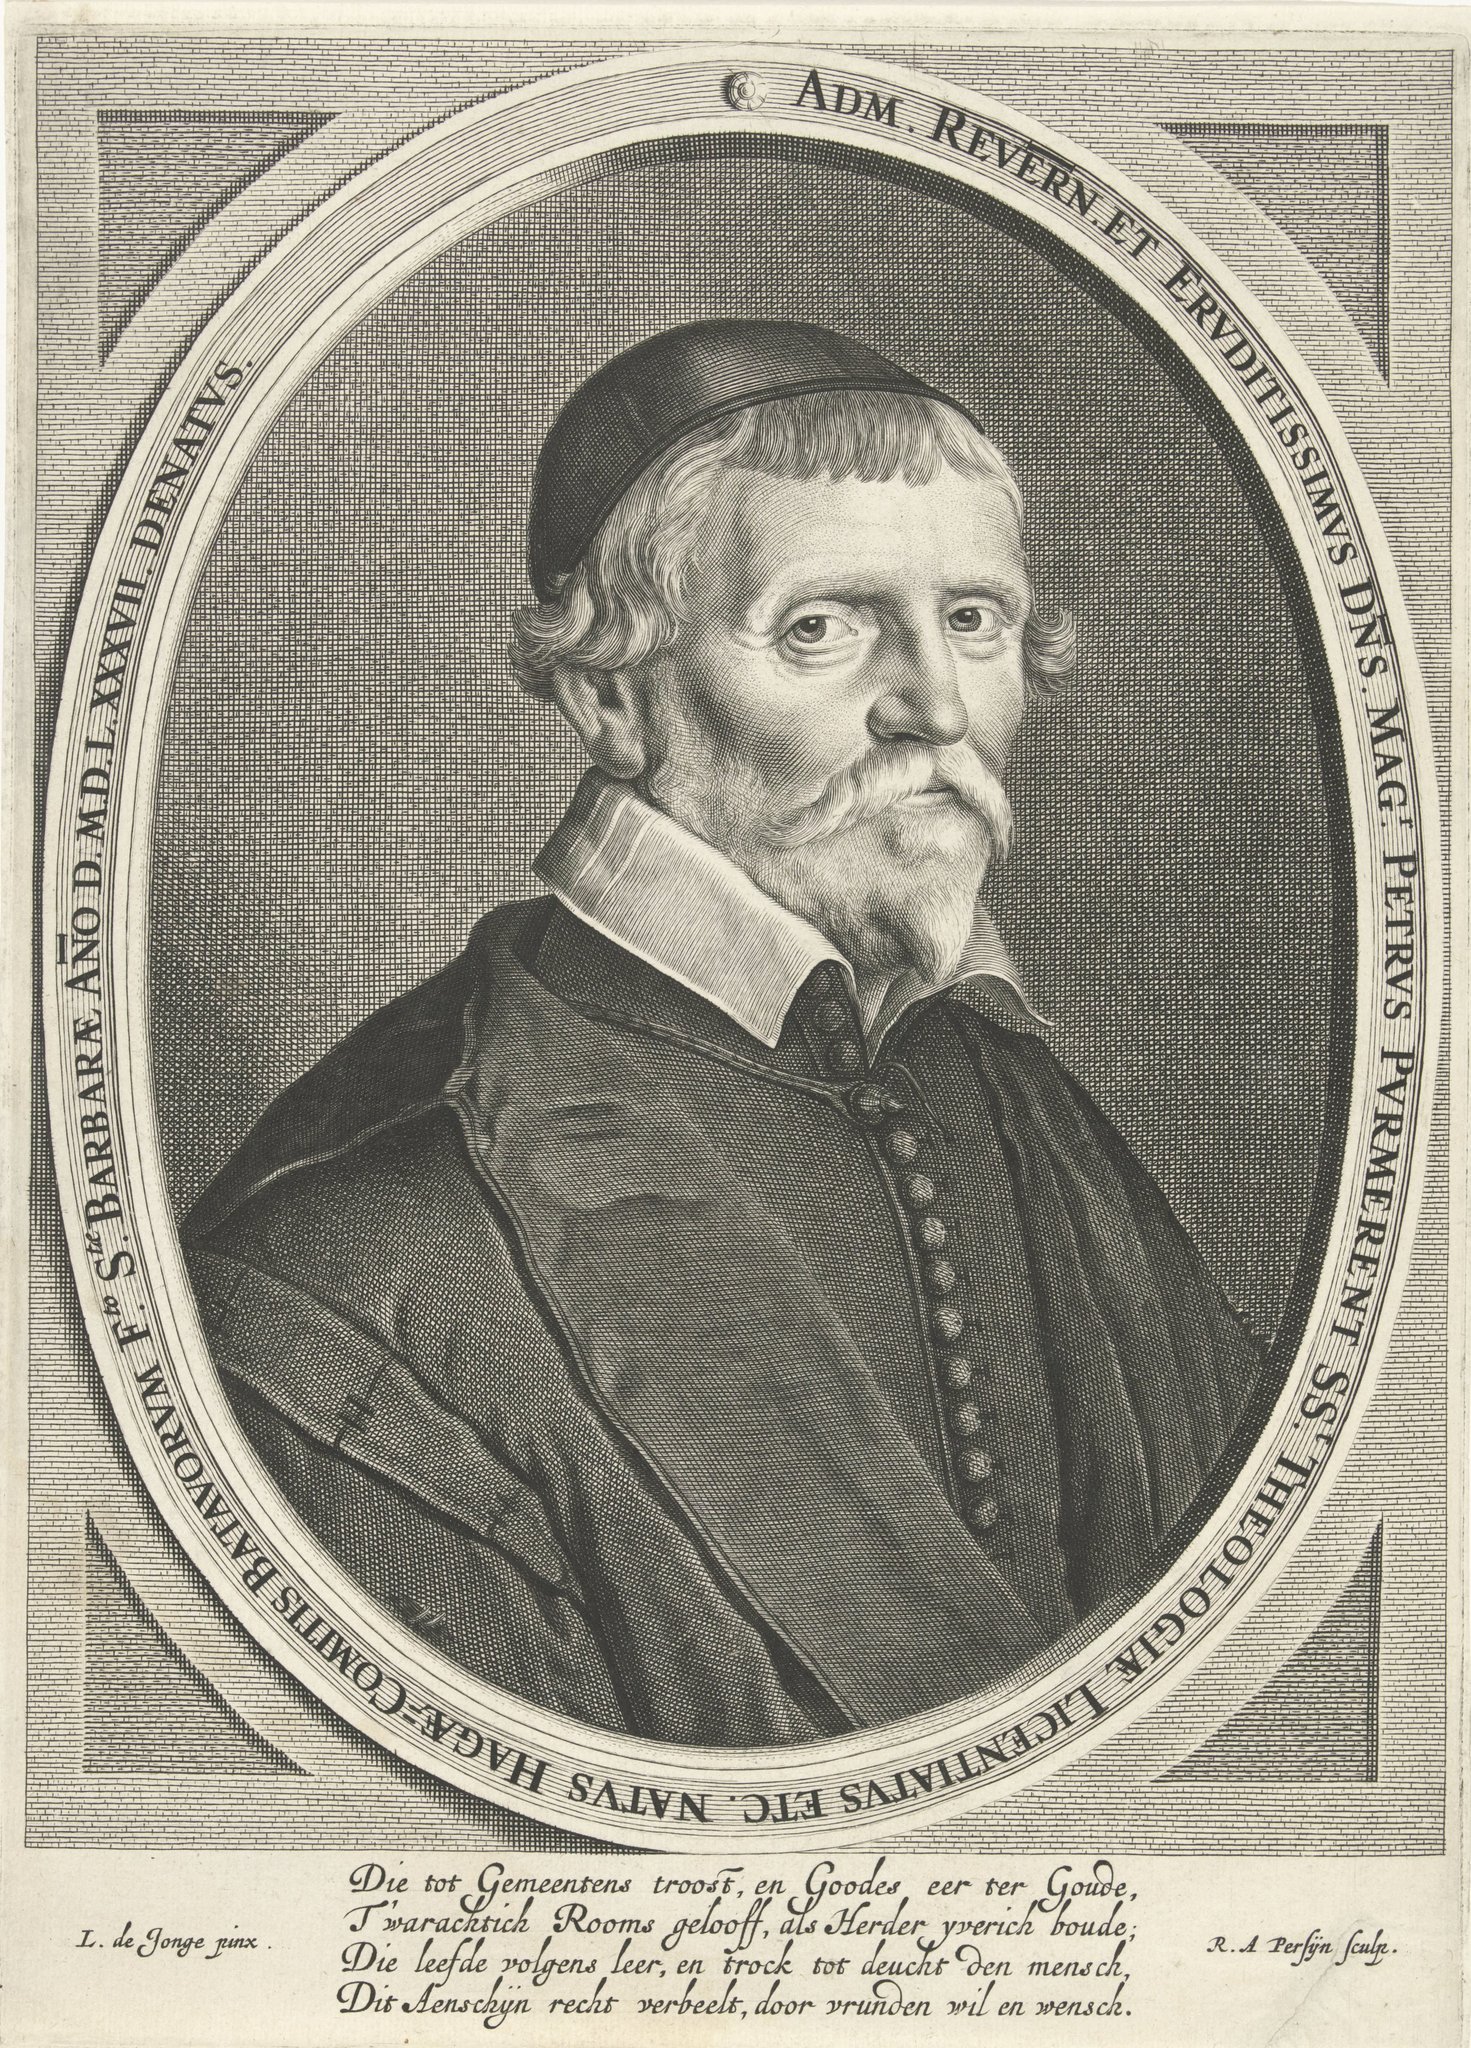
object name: print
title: Portret van Petrus Purmerent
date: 1663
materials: paper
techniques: engraving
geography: gouda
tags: the hague, gouda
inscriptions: collector's mark: Lugt 2228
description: Portret van Petrus Purmerent, pastoor en aartspriester te Gouda. In de marge een vierregelig lofdicht in het Nederlands. Pendant van een portret van zijn tweelingbroer.